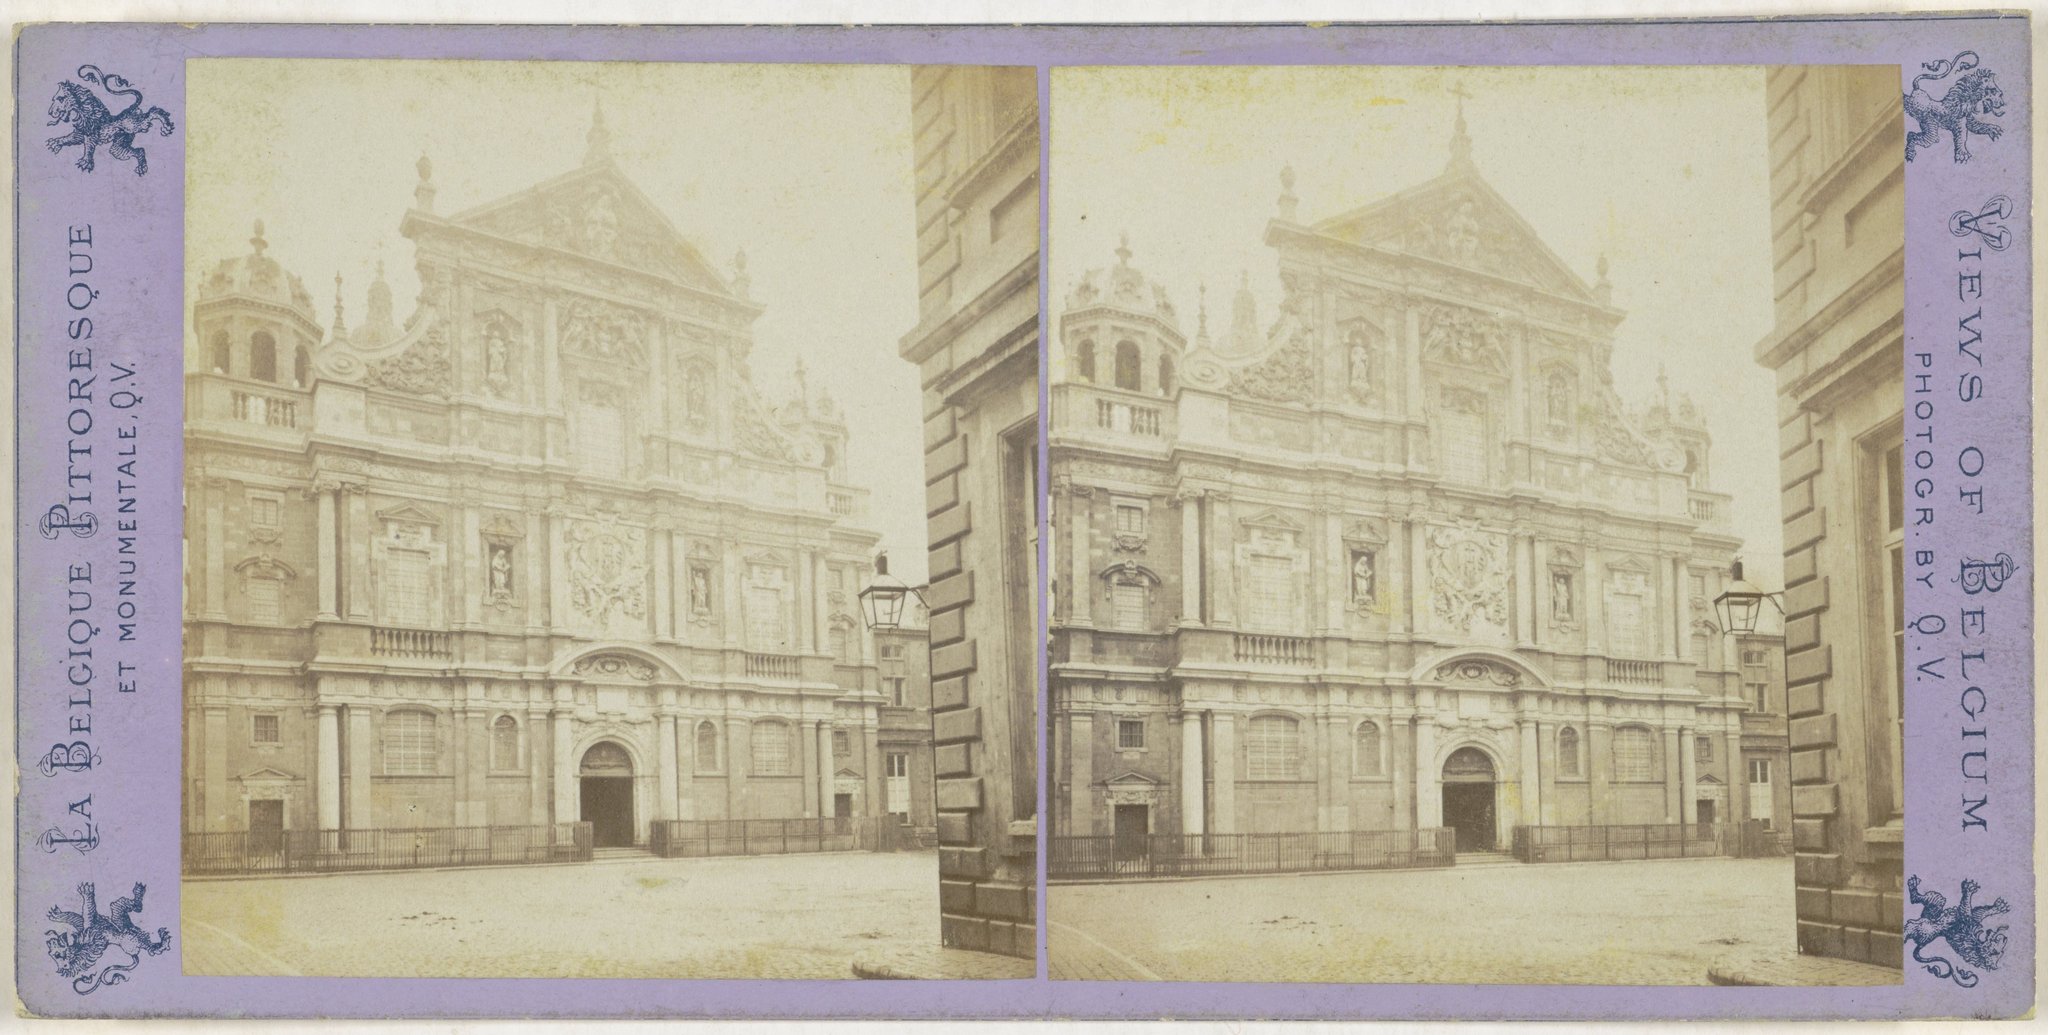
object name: stereograph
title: Anvers, la façade de L'église Saint-Charles, ancienne église des Jésuites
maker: jules hippolyte quéval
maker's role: publisher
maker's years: 1824-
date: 1866-1870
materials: cardboard, paper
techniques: albumen print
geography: antwerp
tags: parts of church exterior and annexes: façade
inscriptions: number: ‘No 1664’